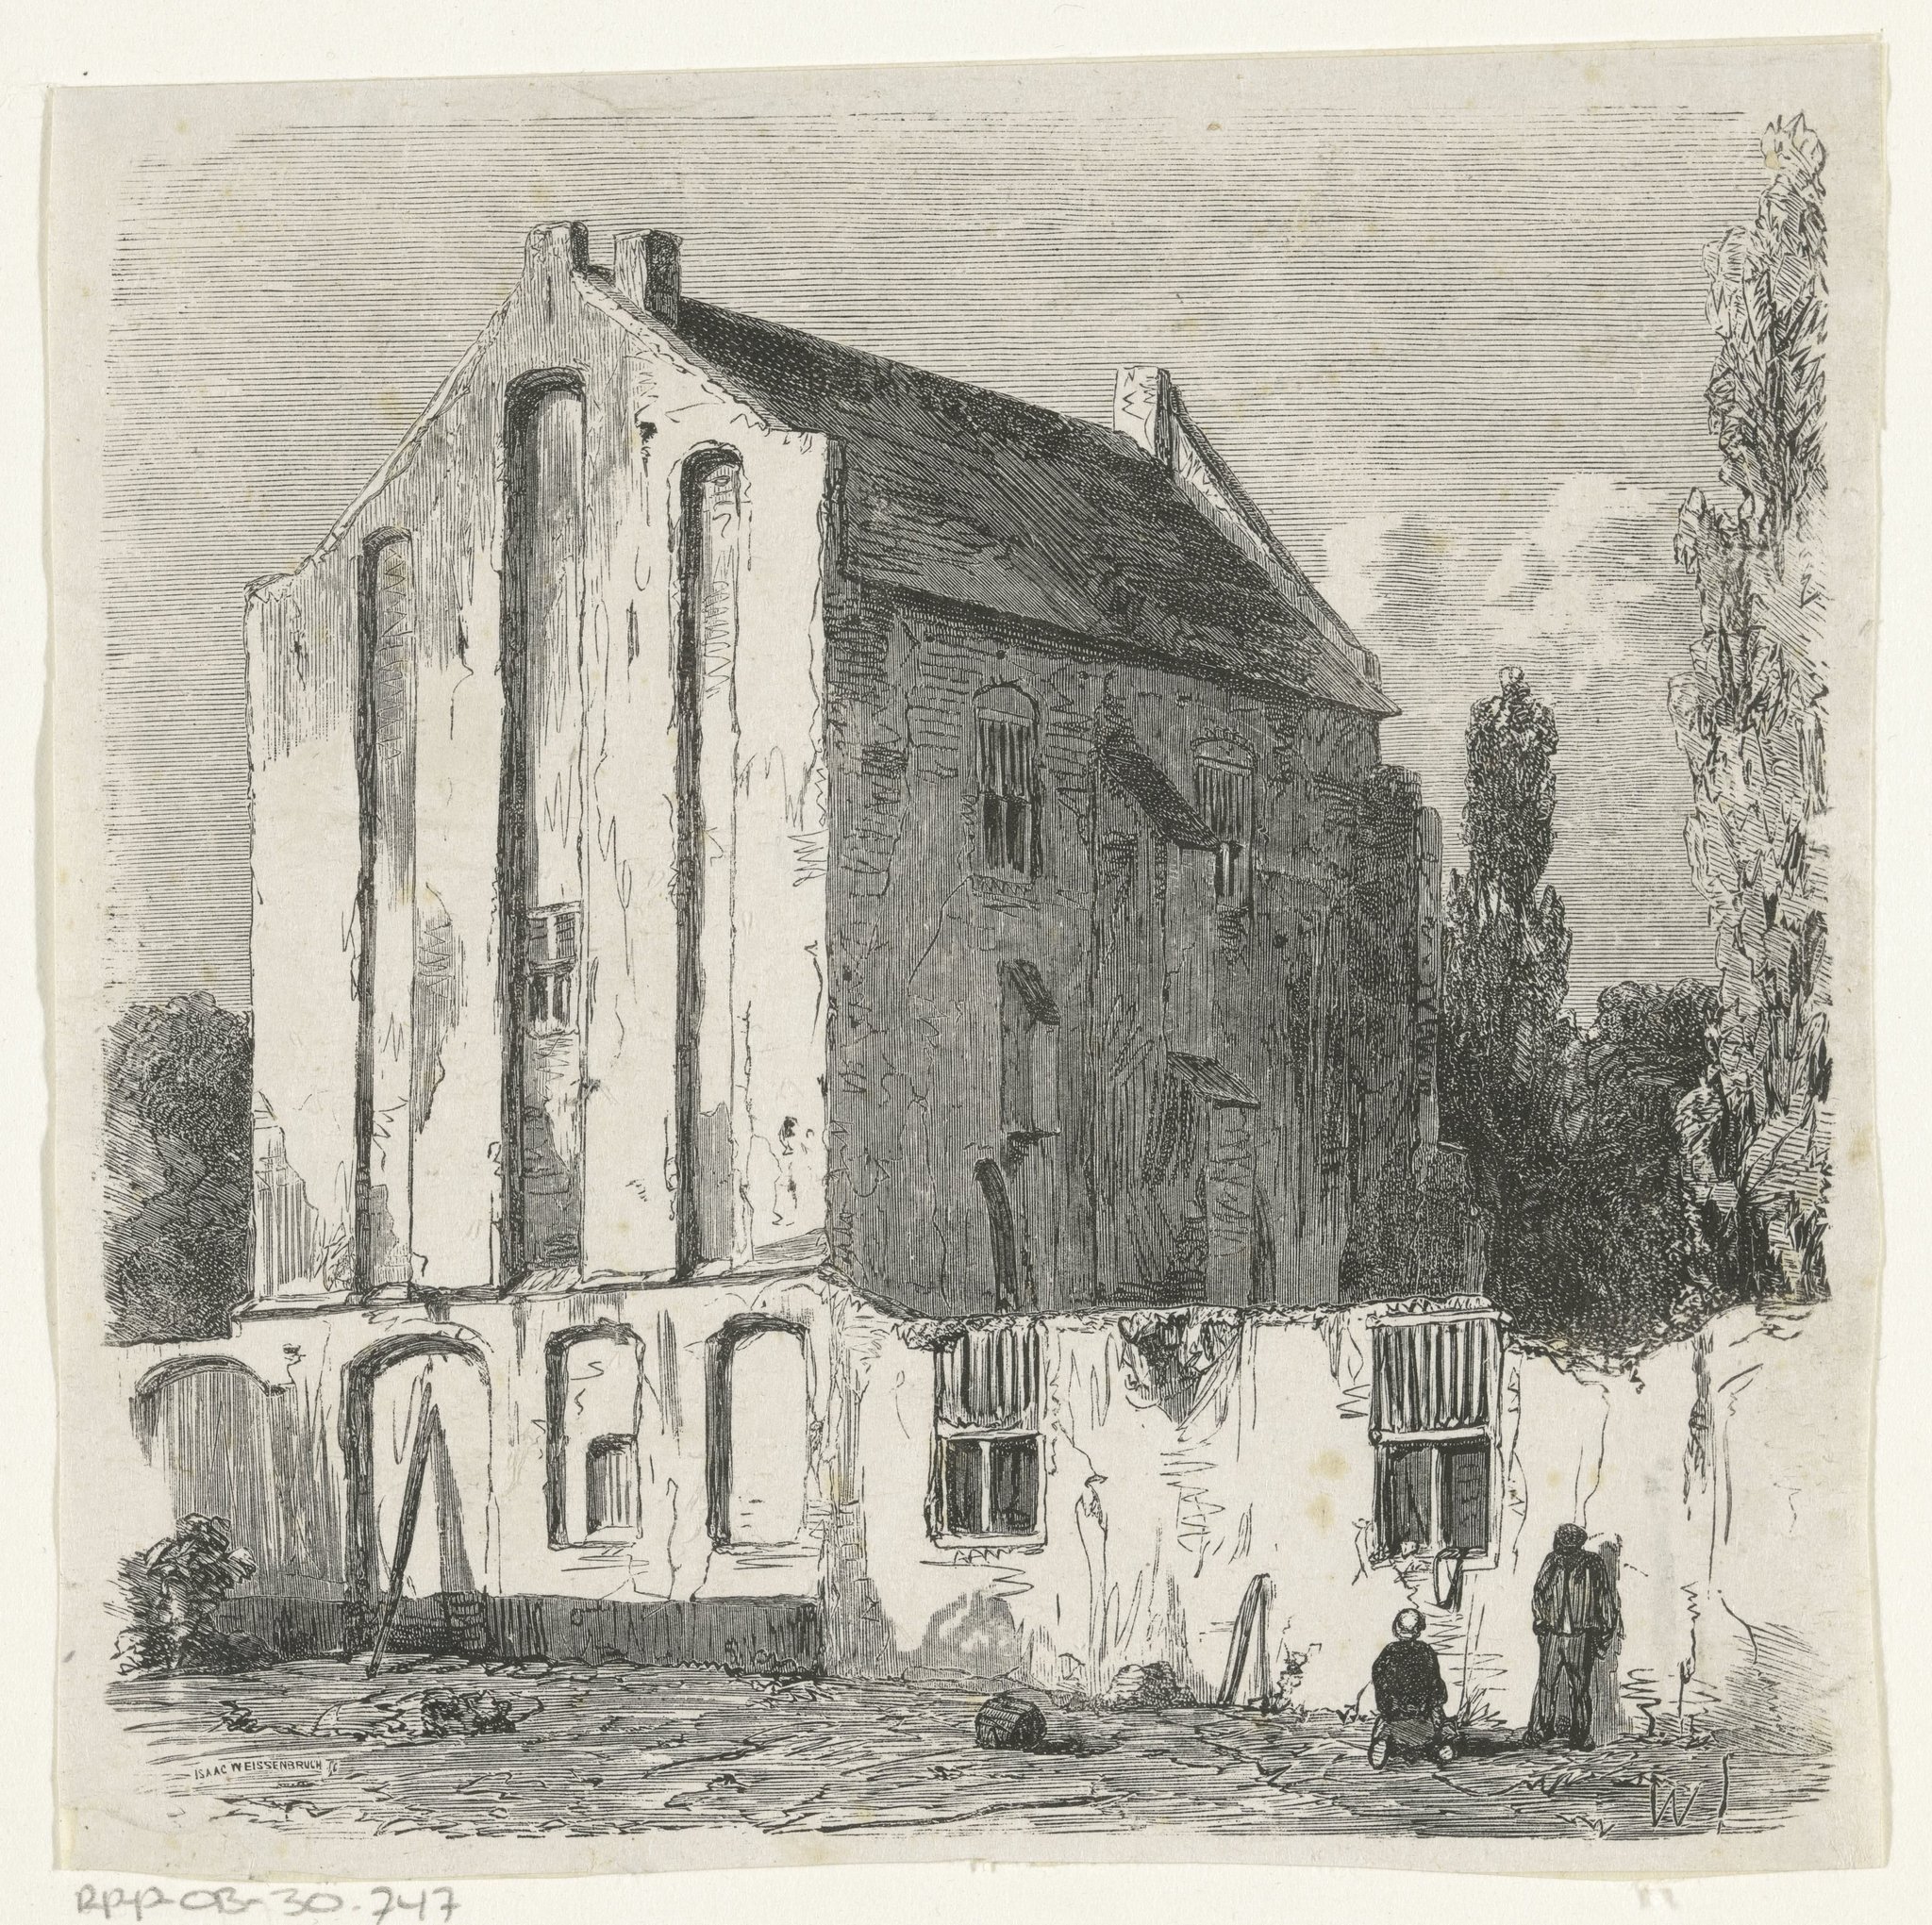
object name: print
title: Bouwwerk met twee figuren bij een muur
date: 1836-1912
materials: paper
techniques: engraving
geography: netherlands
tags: standing figure, civic architecture; edifices; dwellings, kneeling on both knees